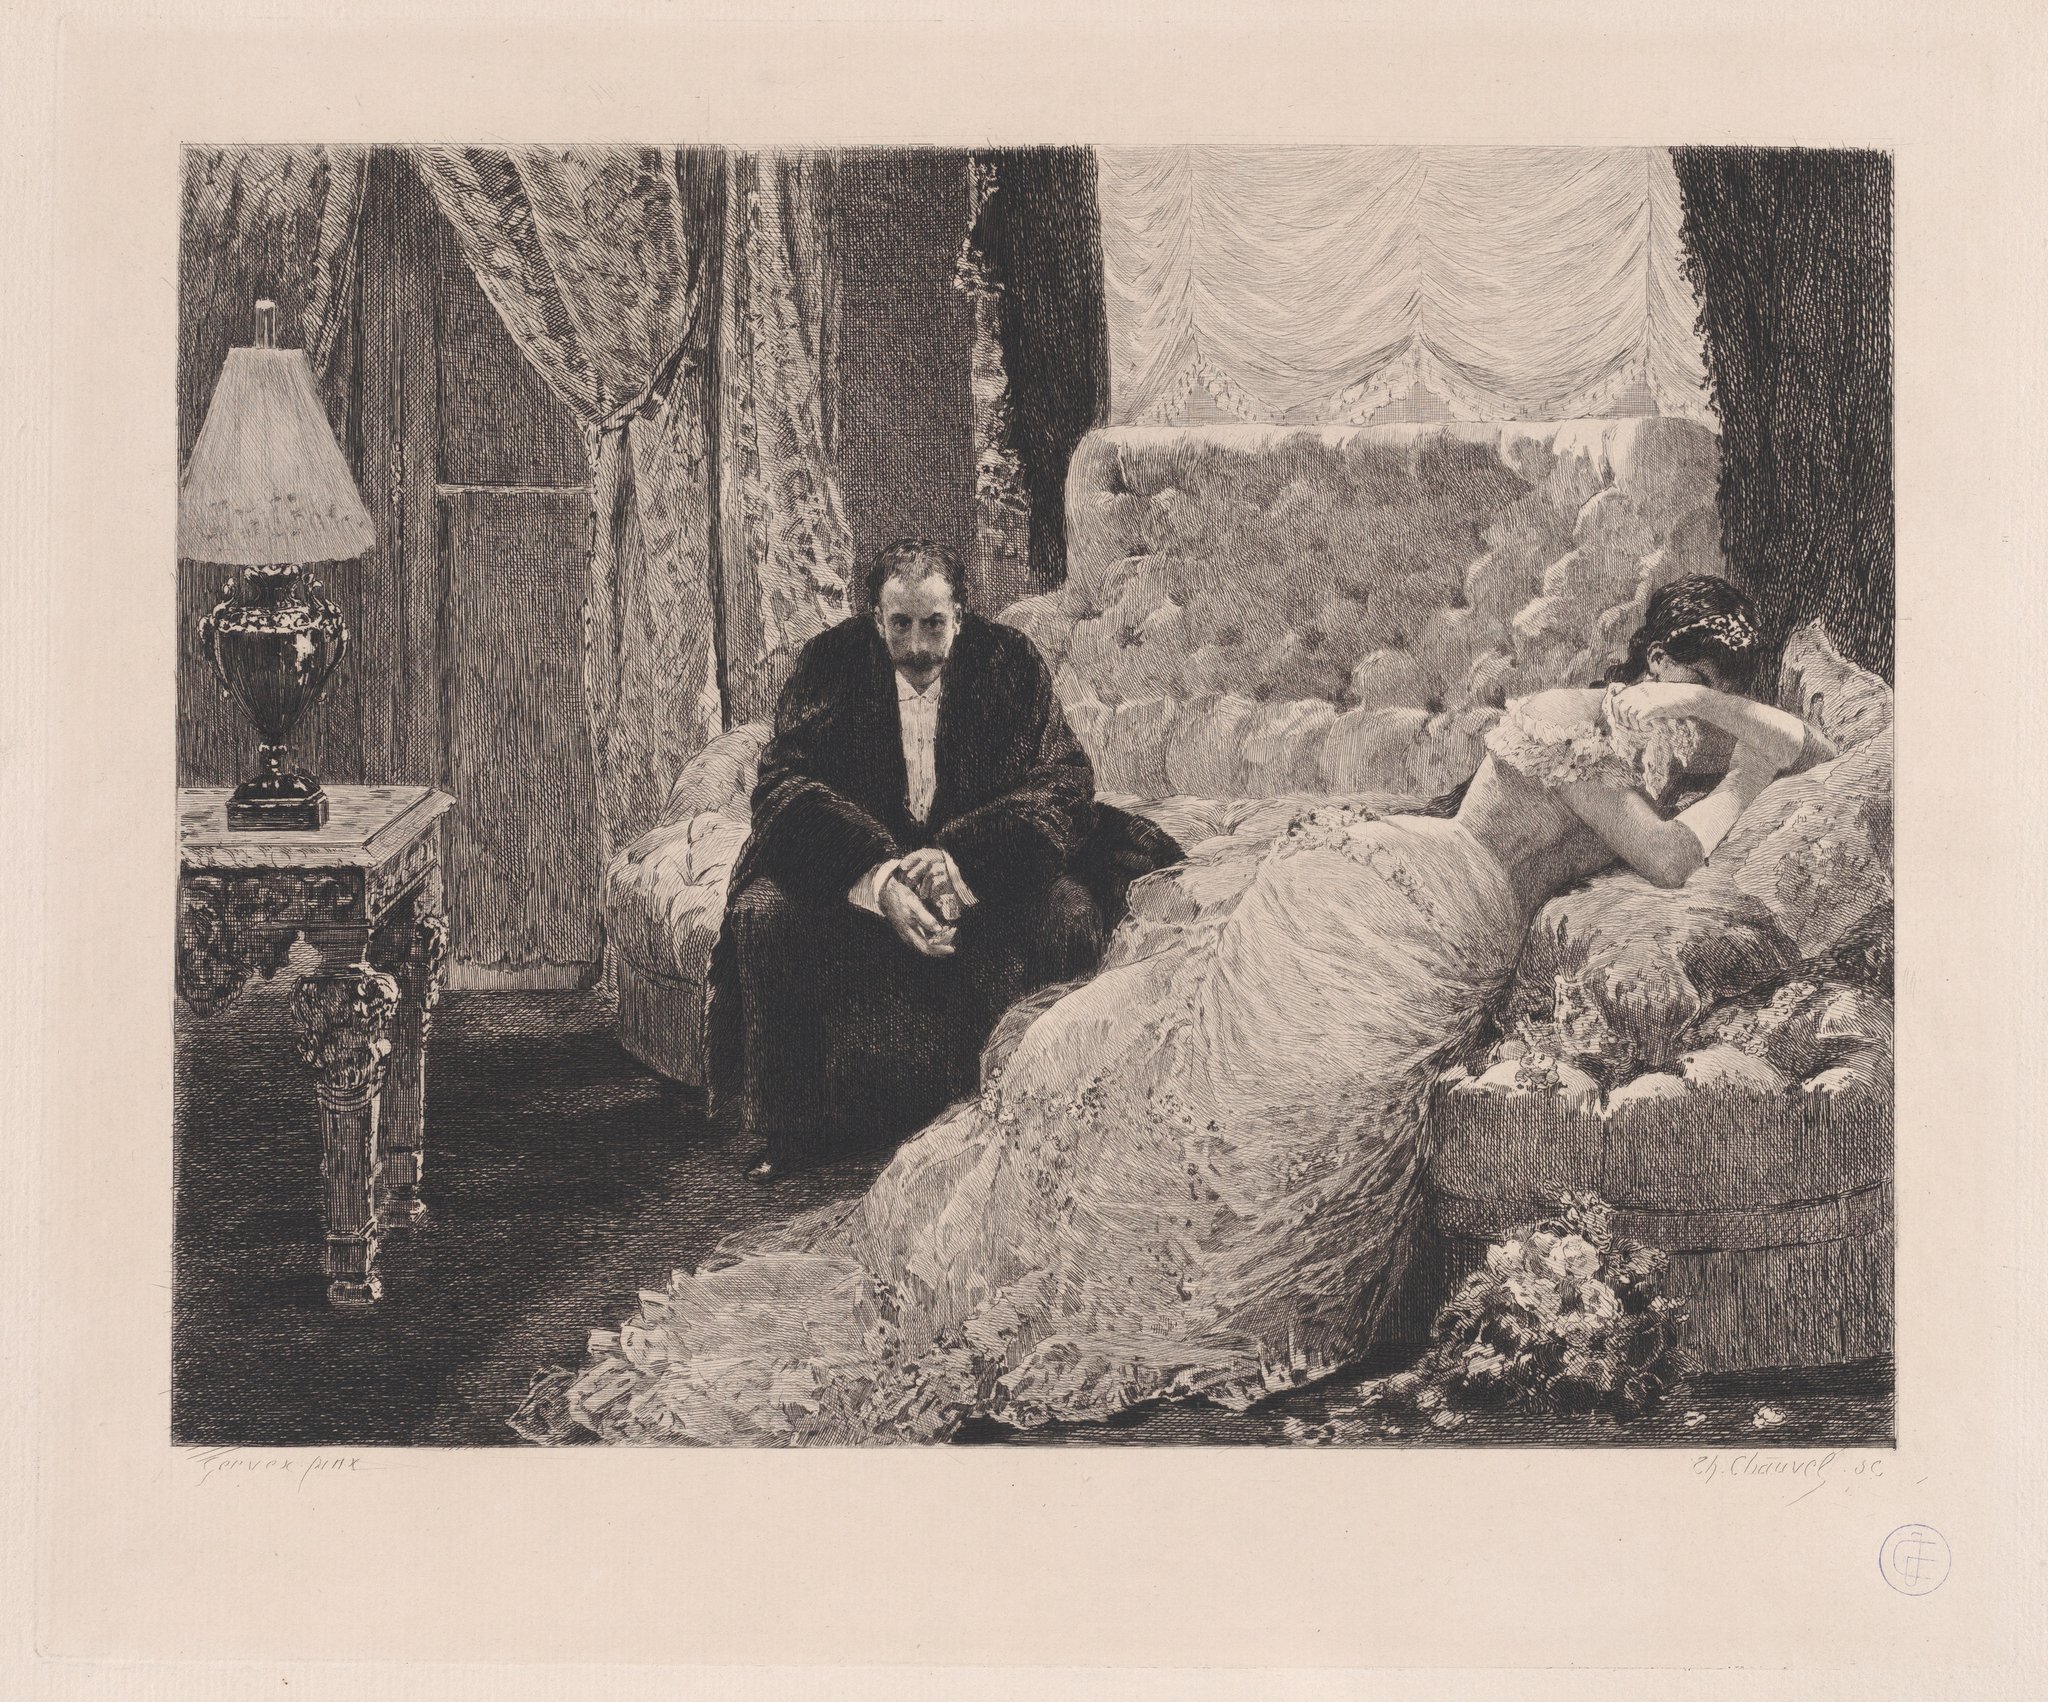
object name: print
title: Return from the Ball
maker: théophile chauvel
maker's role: artist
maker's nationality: french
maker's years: 1831-1909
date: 1879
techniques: etching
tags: interiors,men,women